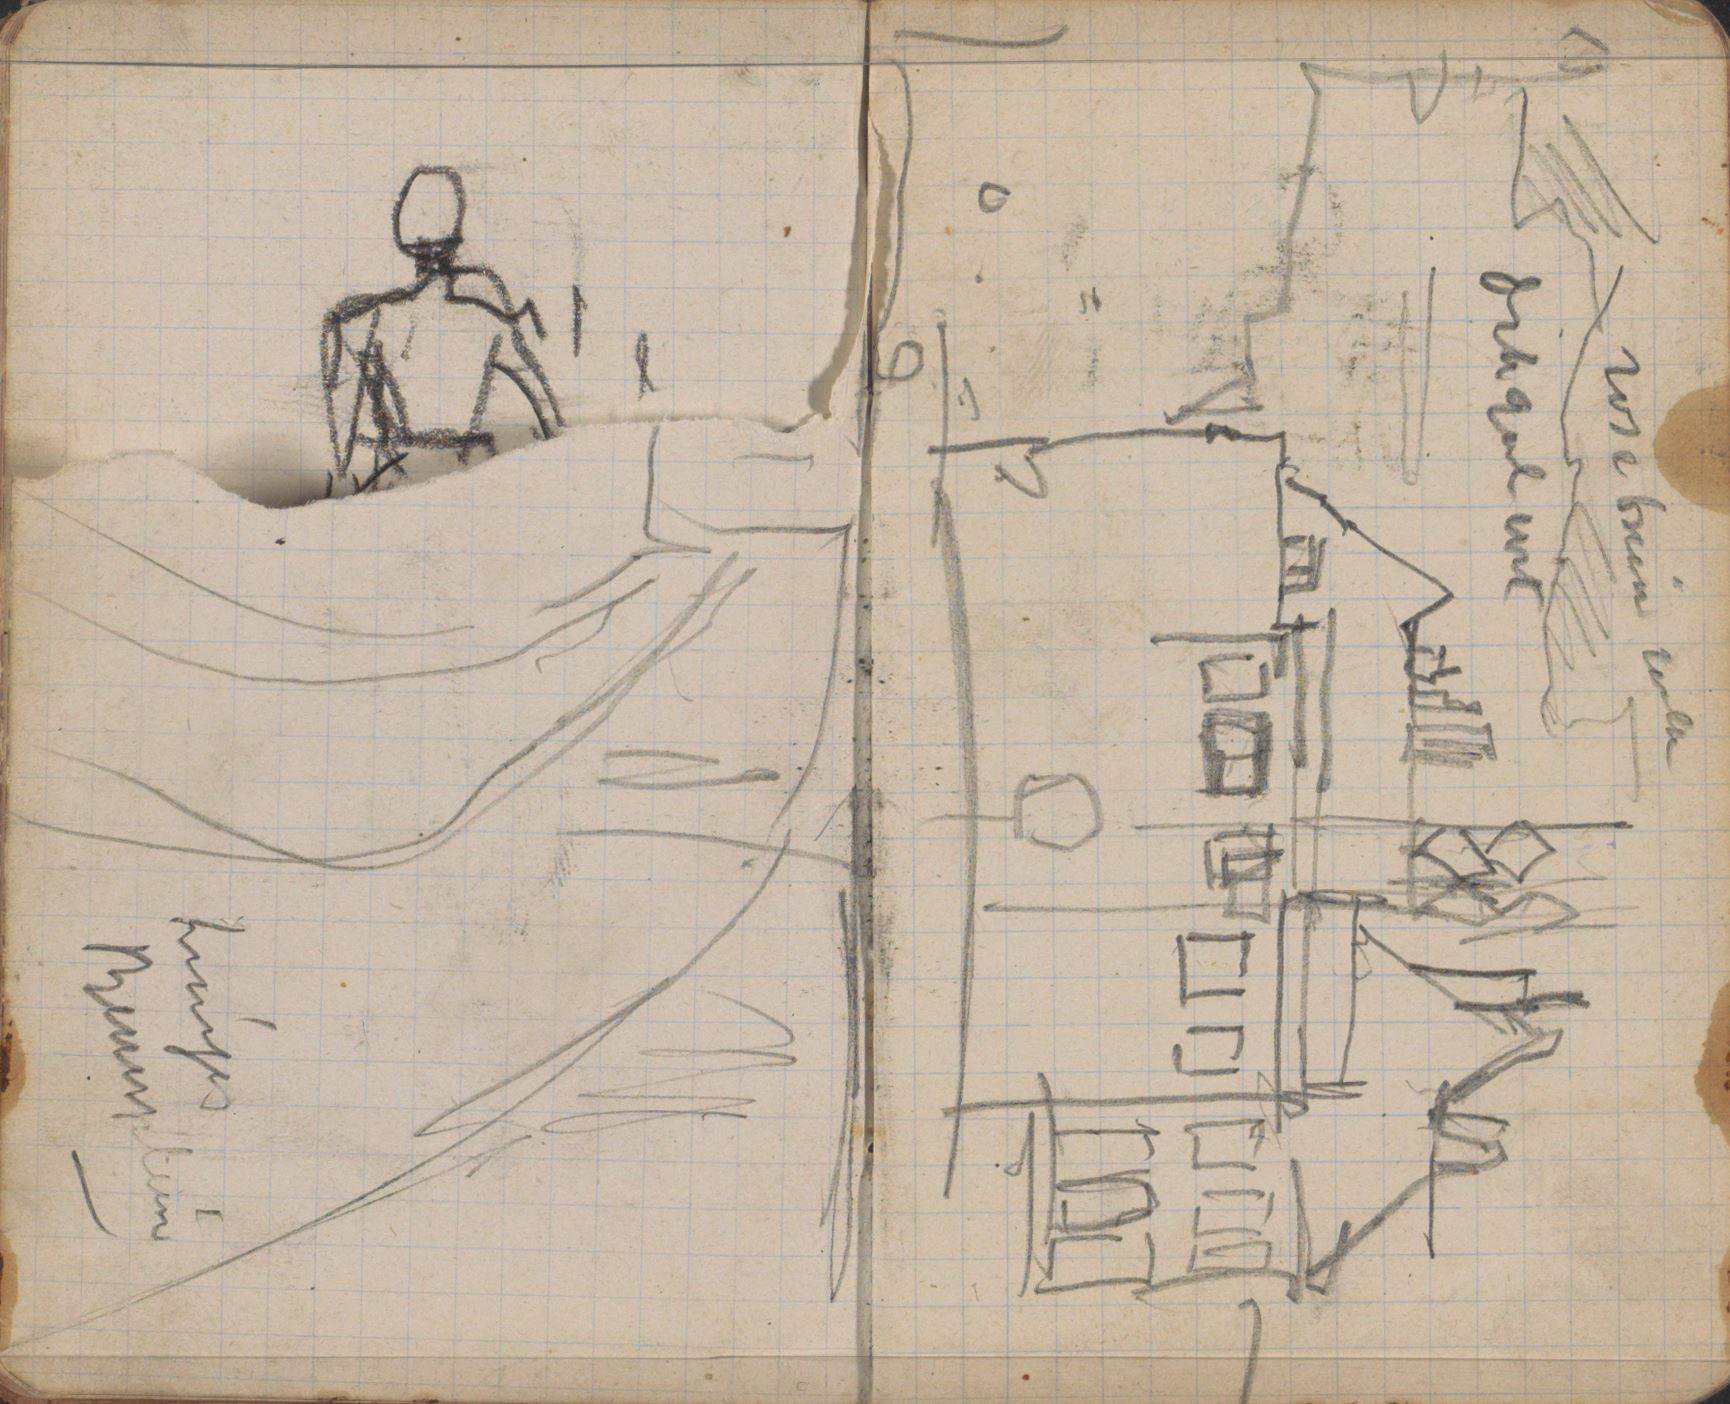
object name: sketchbook leaf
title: Gezicht op het Beursplein te Amsterdam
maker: george hendrik breitner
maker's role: draughtsman, painter, print maker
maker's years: 1857-1923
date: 1893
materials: pencil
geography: amsterdam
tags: square, place, circus, etc., urban housing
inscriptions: annotation: ‘huisjes/ Beursplein’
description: Pagina 15 en pagina 16 uit een schetsboek met 30 bladen vervaardigd in Amsterdam.